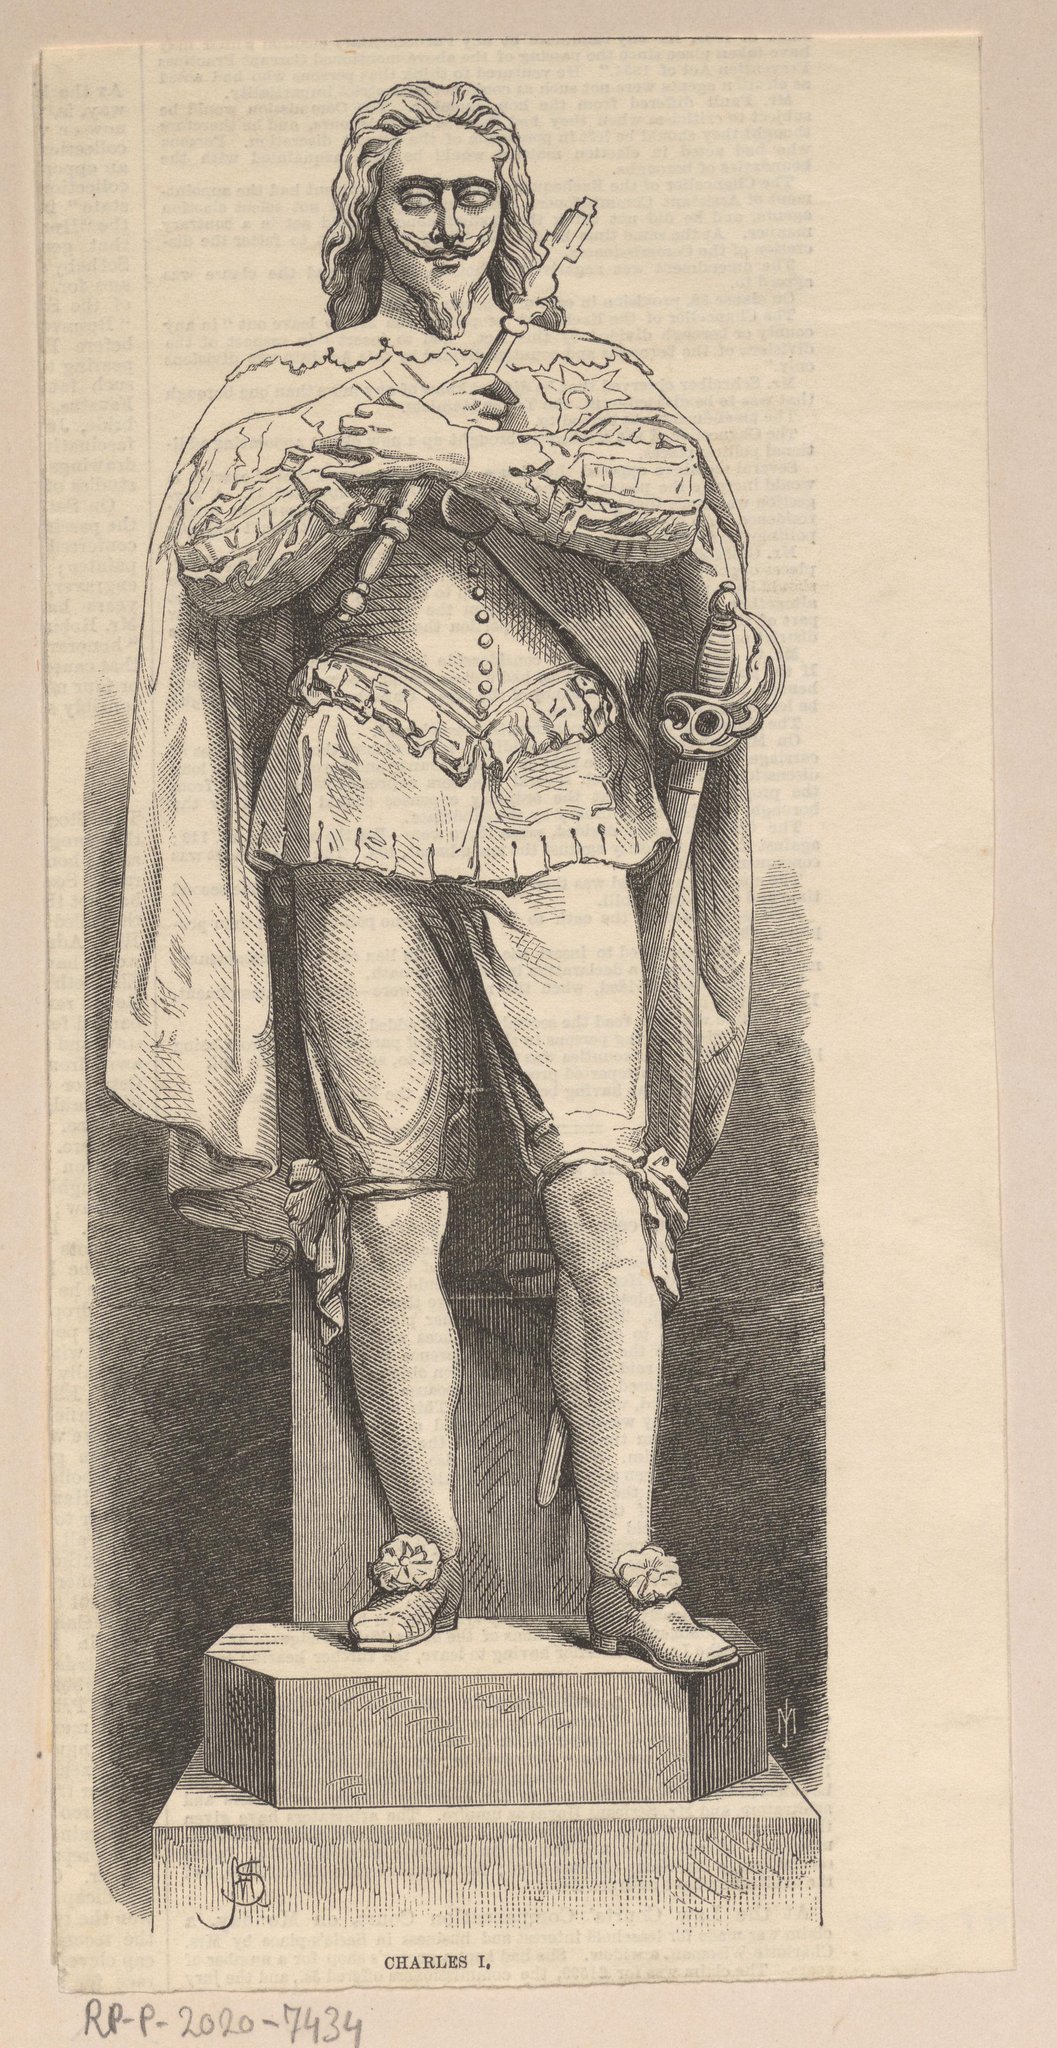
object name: print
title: Portret van Karel I, koning van Engeland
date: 1825-1899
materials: paper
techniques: letterpress printing, engraving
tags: karel i (koning van engeland), sceptre, staff (symbol of sovereignty), historical persons, king